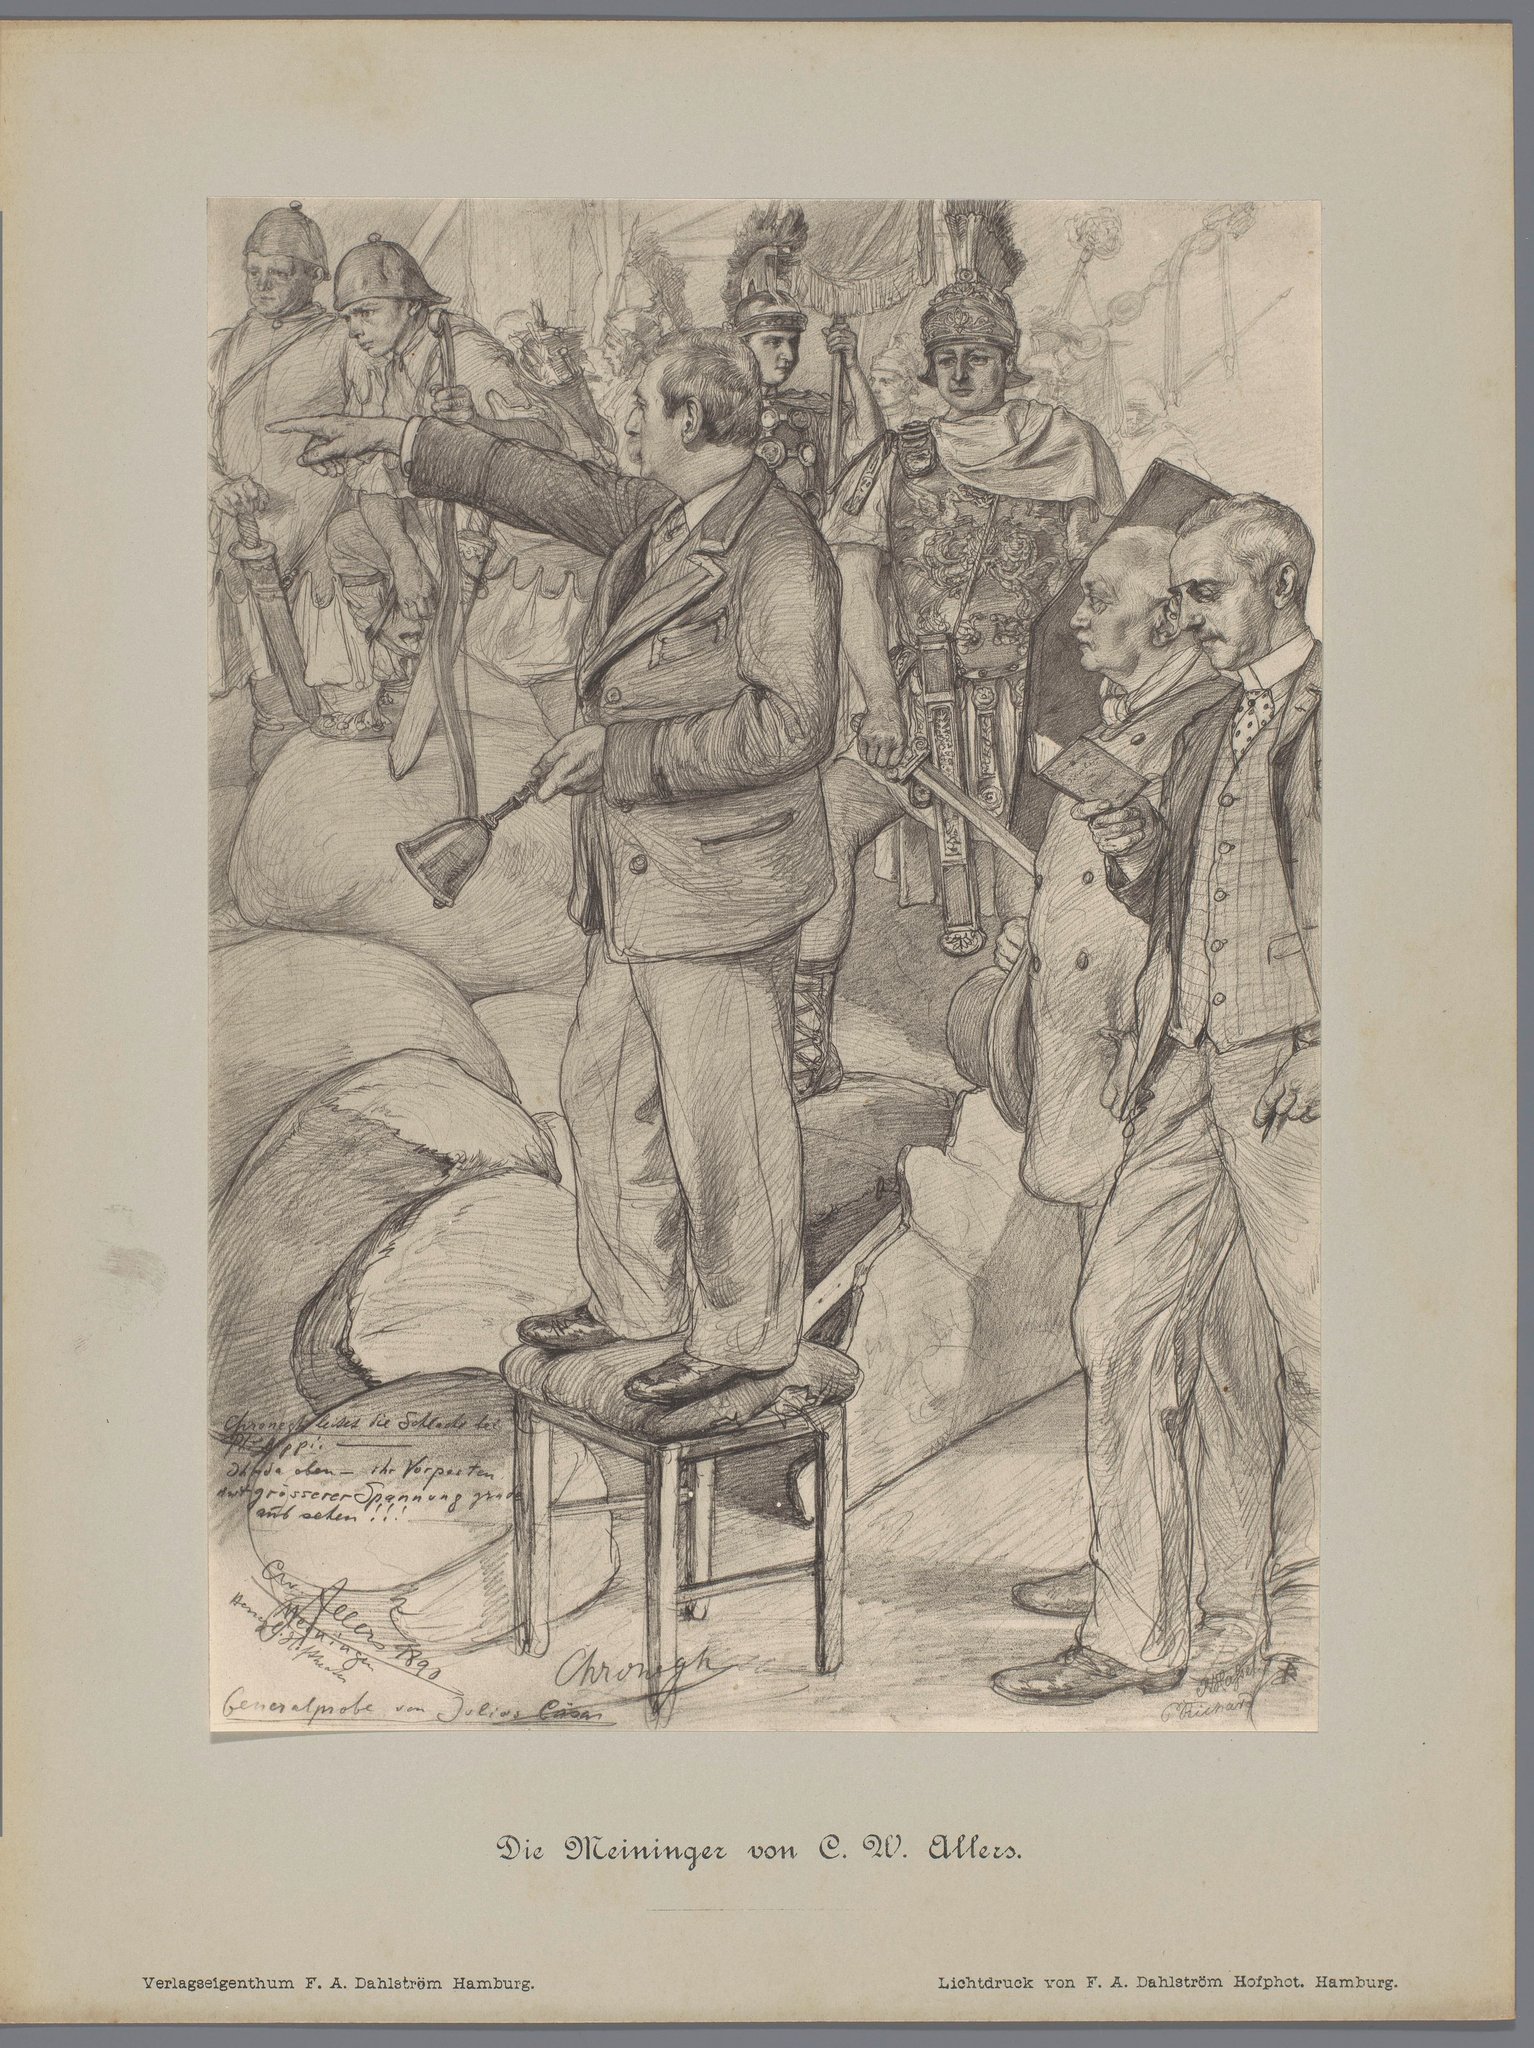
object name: photomechanical print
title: Fotoreproductie van een tekening, voorstellende Ludwig Chronegk leidt de generale repetitie van het toneelstuk Julius Caesar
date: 1890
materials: paper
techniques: photograph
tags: director, producer ~ the stage, rehearsal, studying the role ~ theatre